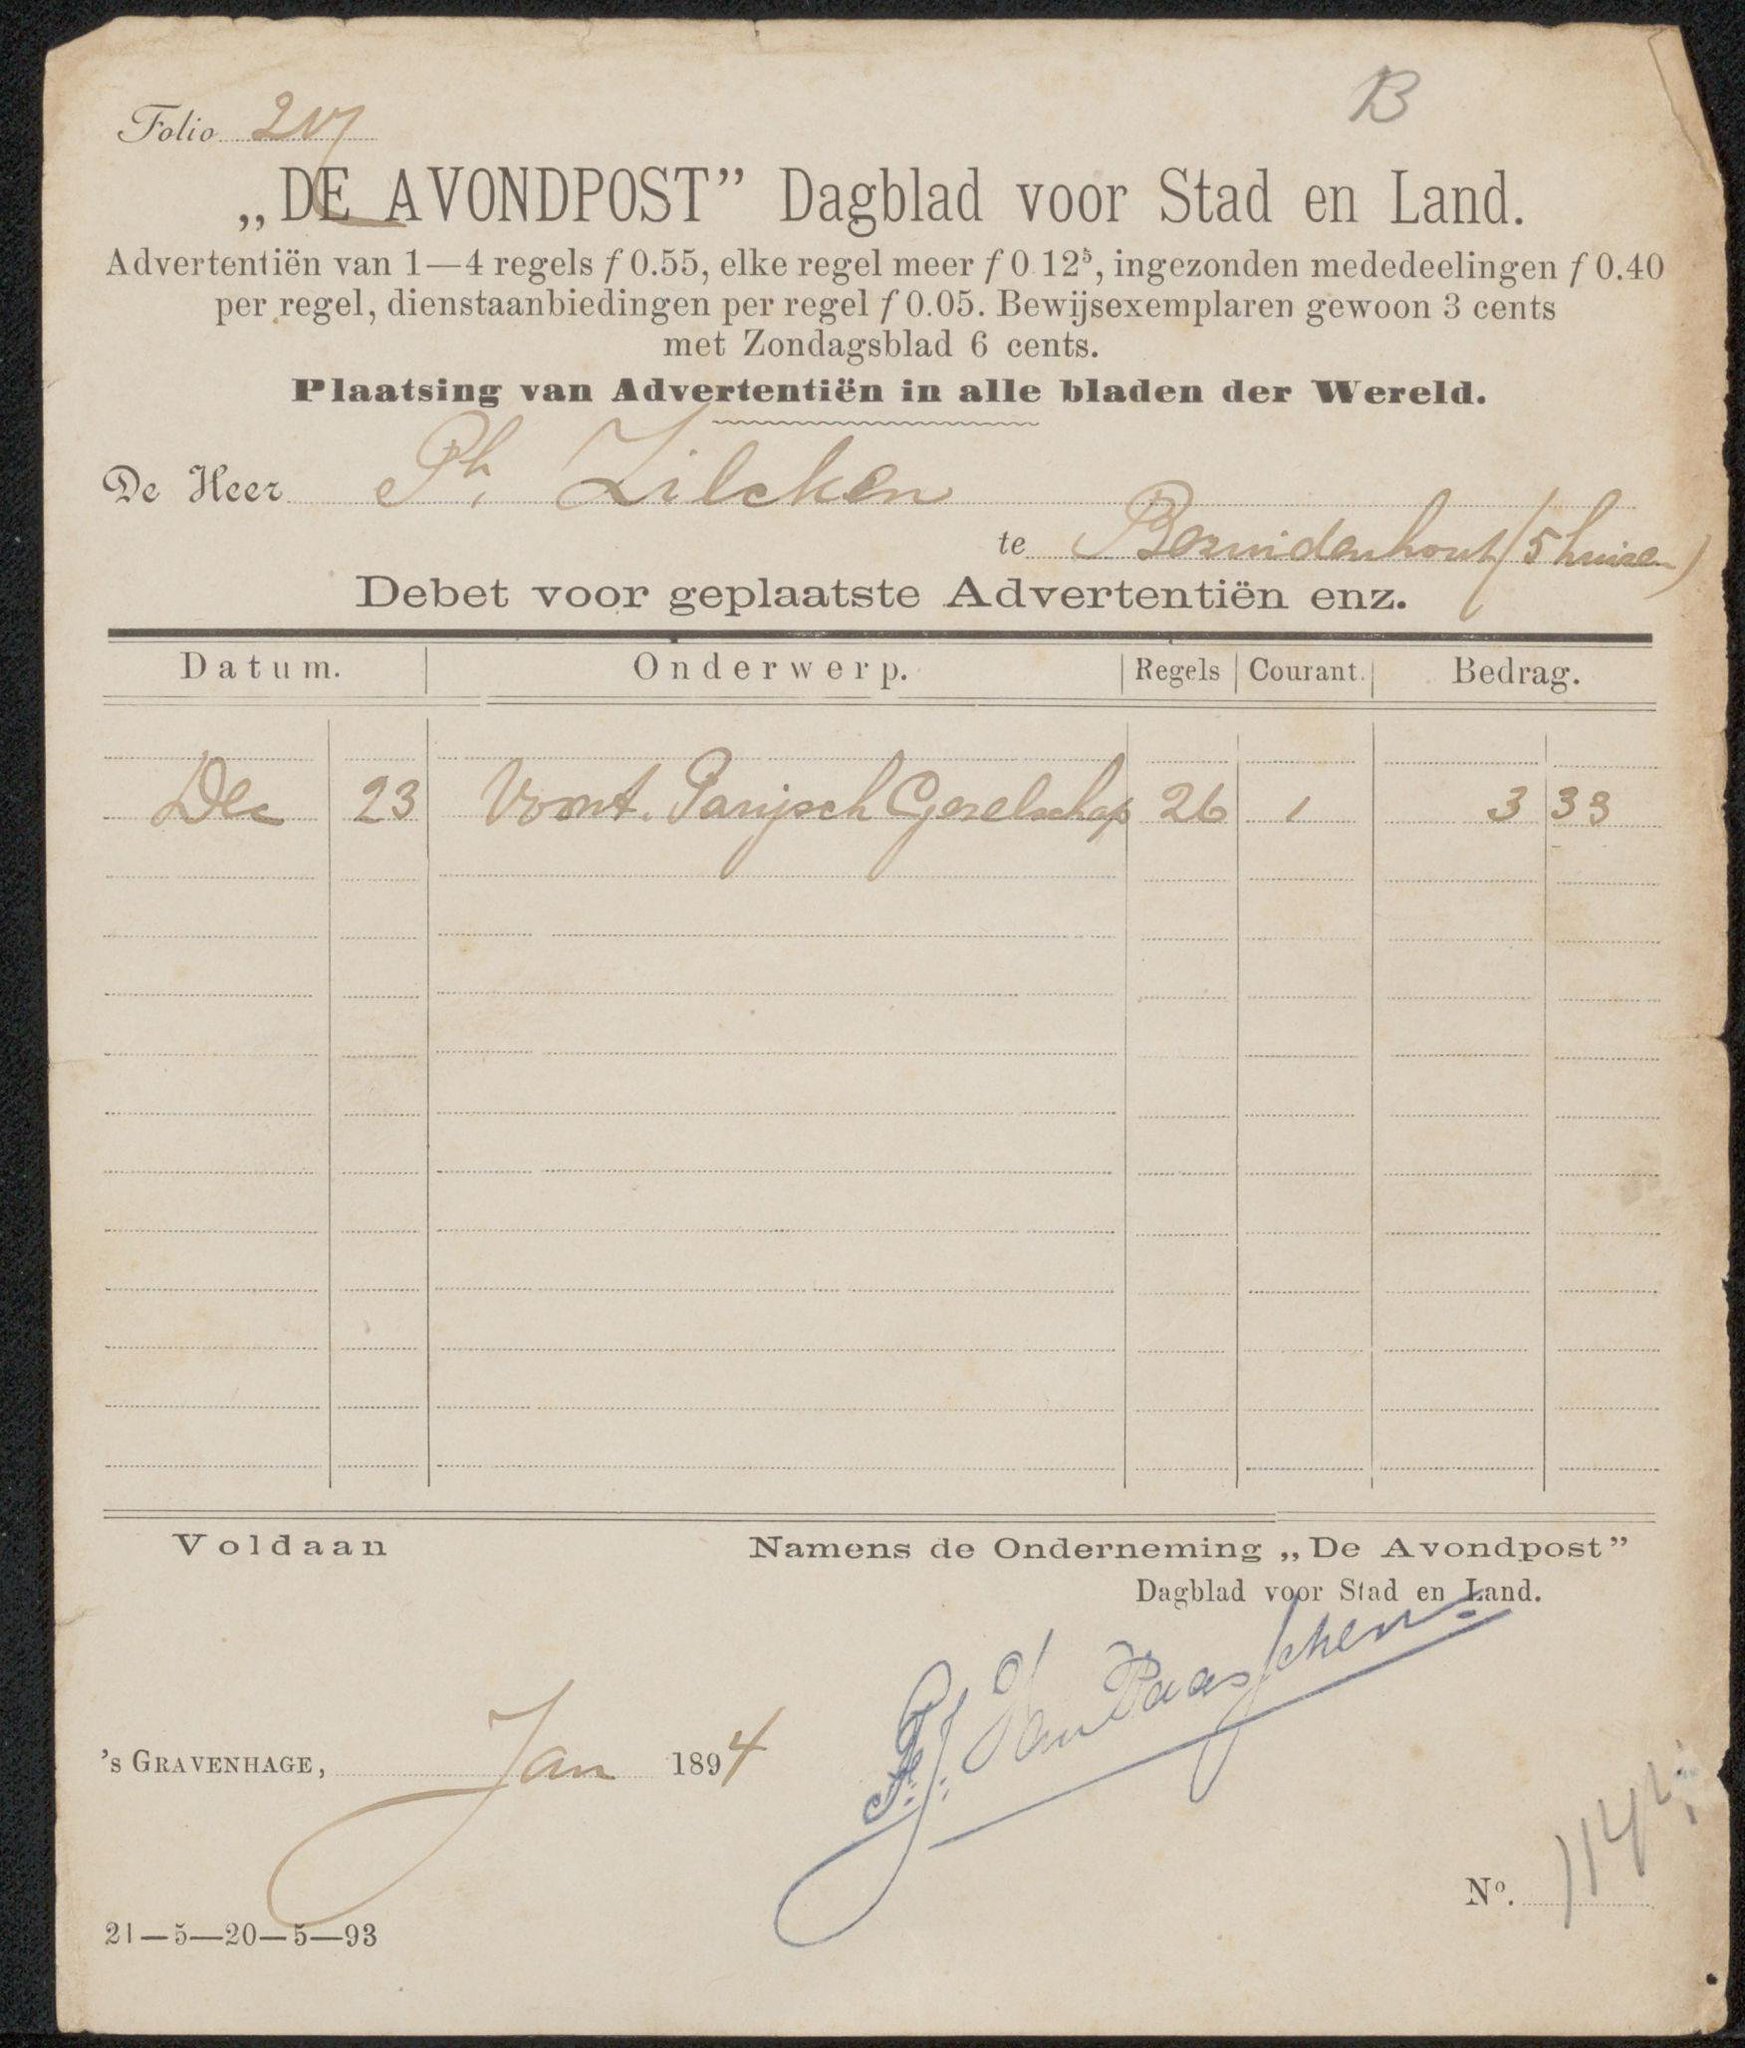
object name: nota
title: Nota aan Philip Zilcken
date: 1801-1894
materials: chalk, ink, paper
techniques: pen, printing, writing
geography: the hague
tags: the hague, painter, philip zilcken, sitting figure - aa - female human figure, the arts of the stage: ballet, theatre, musical drama, motion picture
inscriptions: collector's mark: ‘RPK’